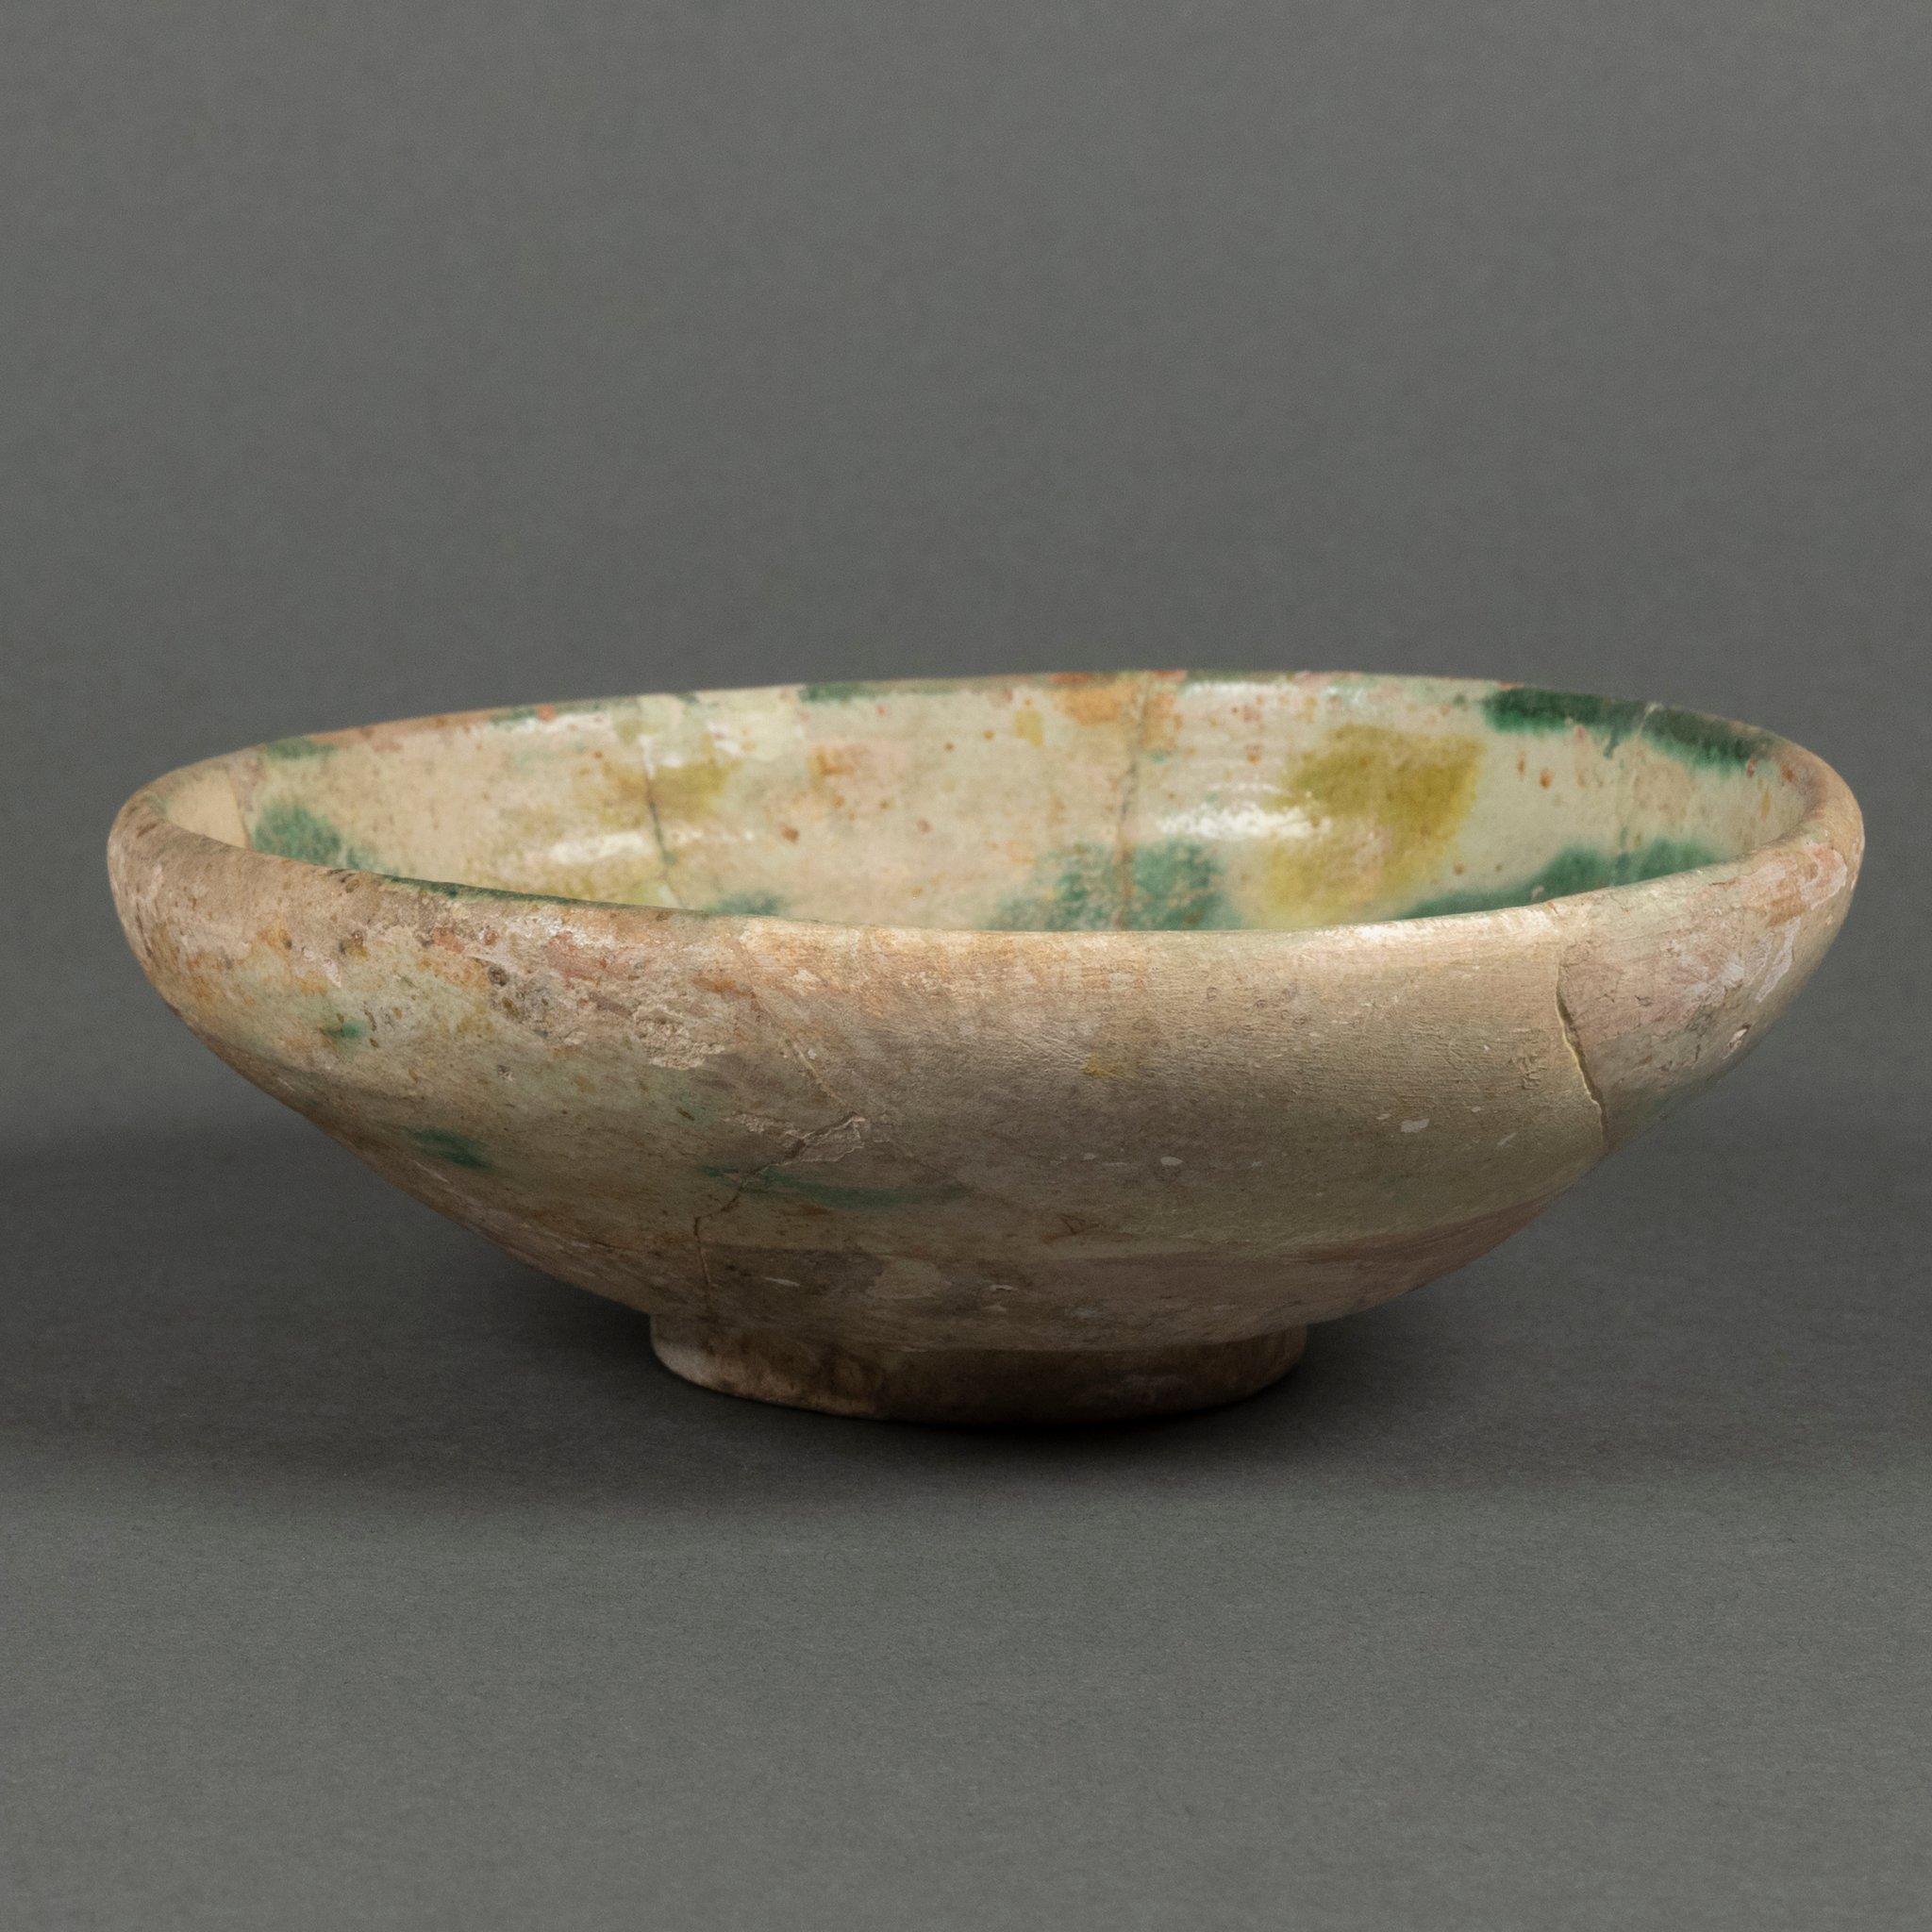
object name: bowl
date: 801-1000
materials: earthenware, glaze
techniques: polychrome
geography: iran